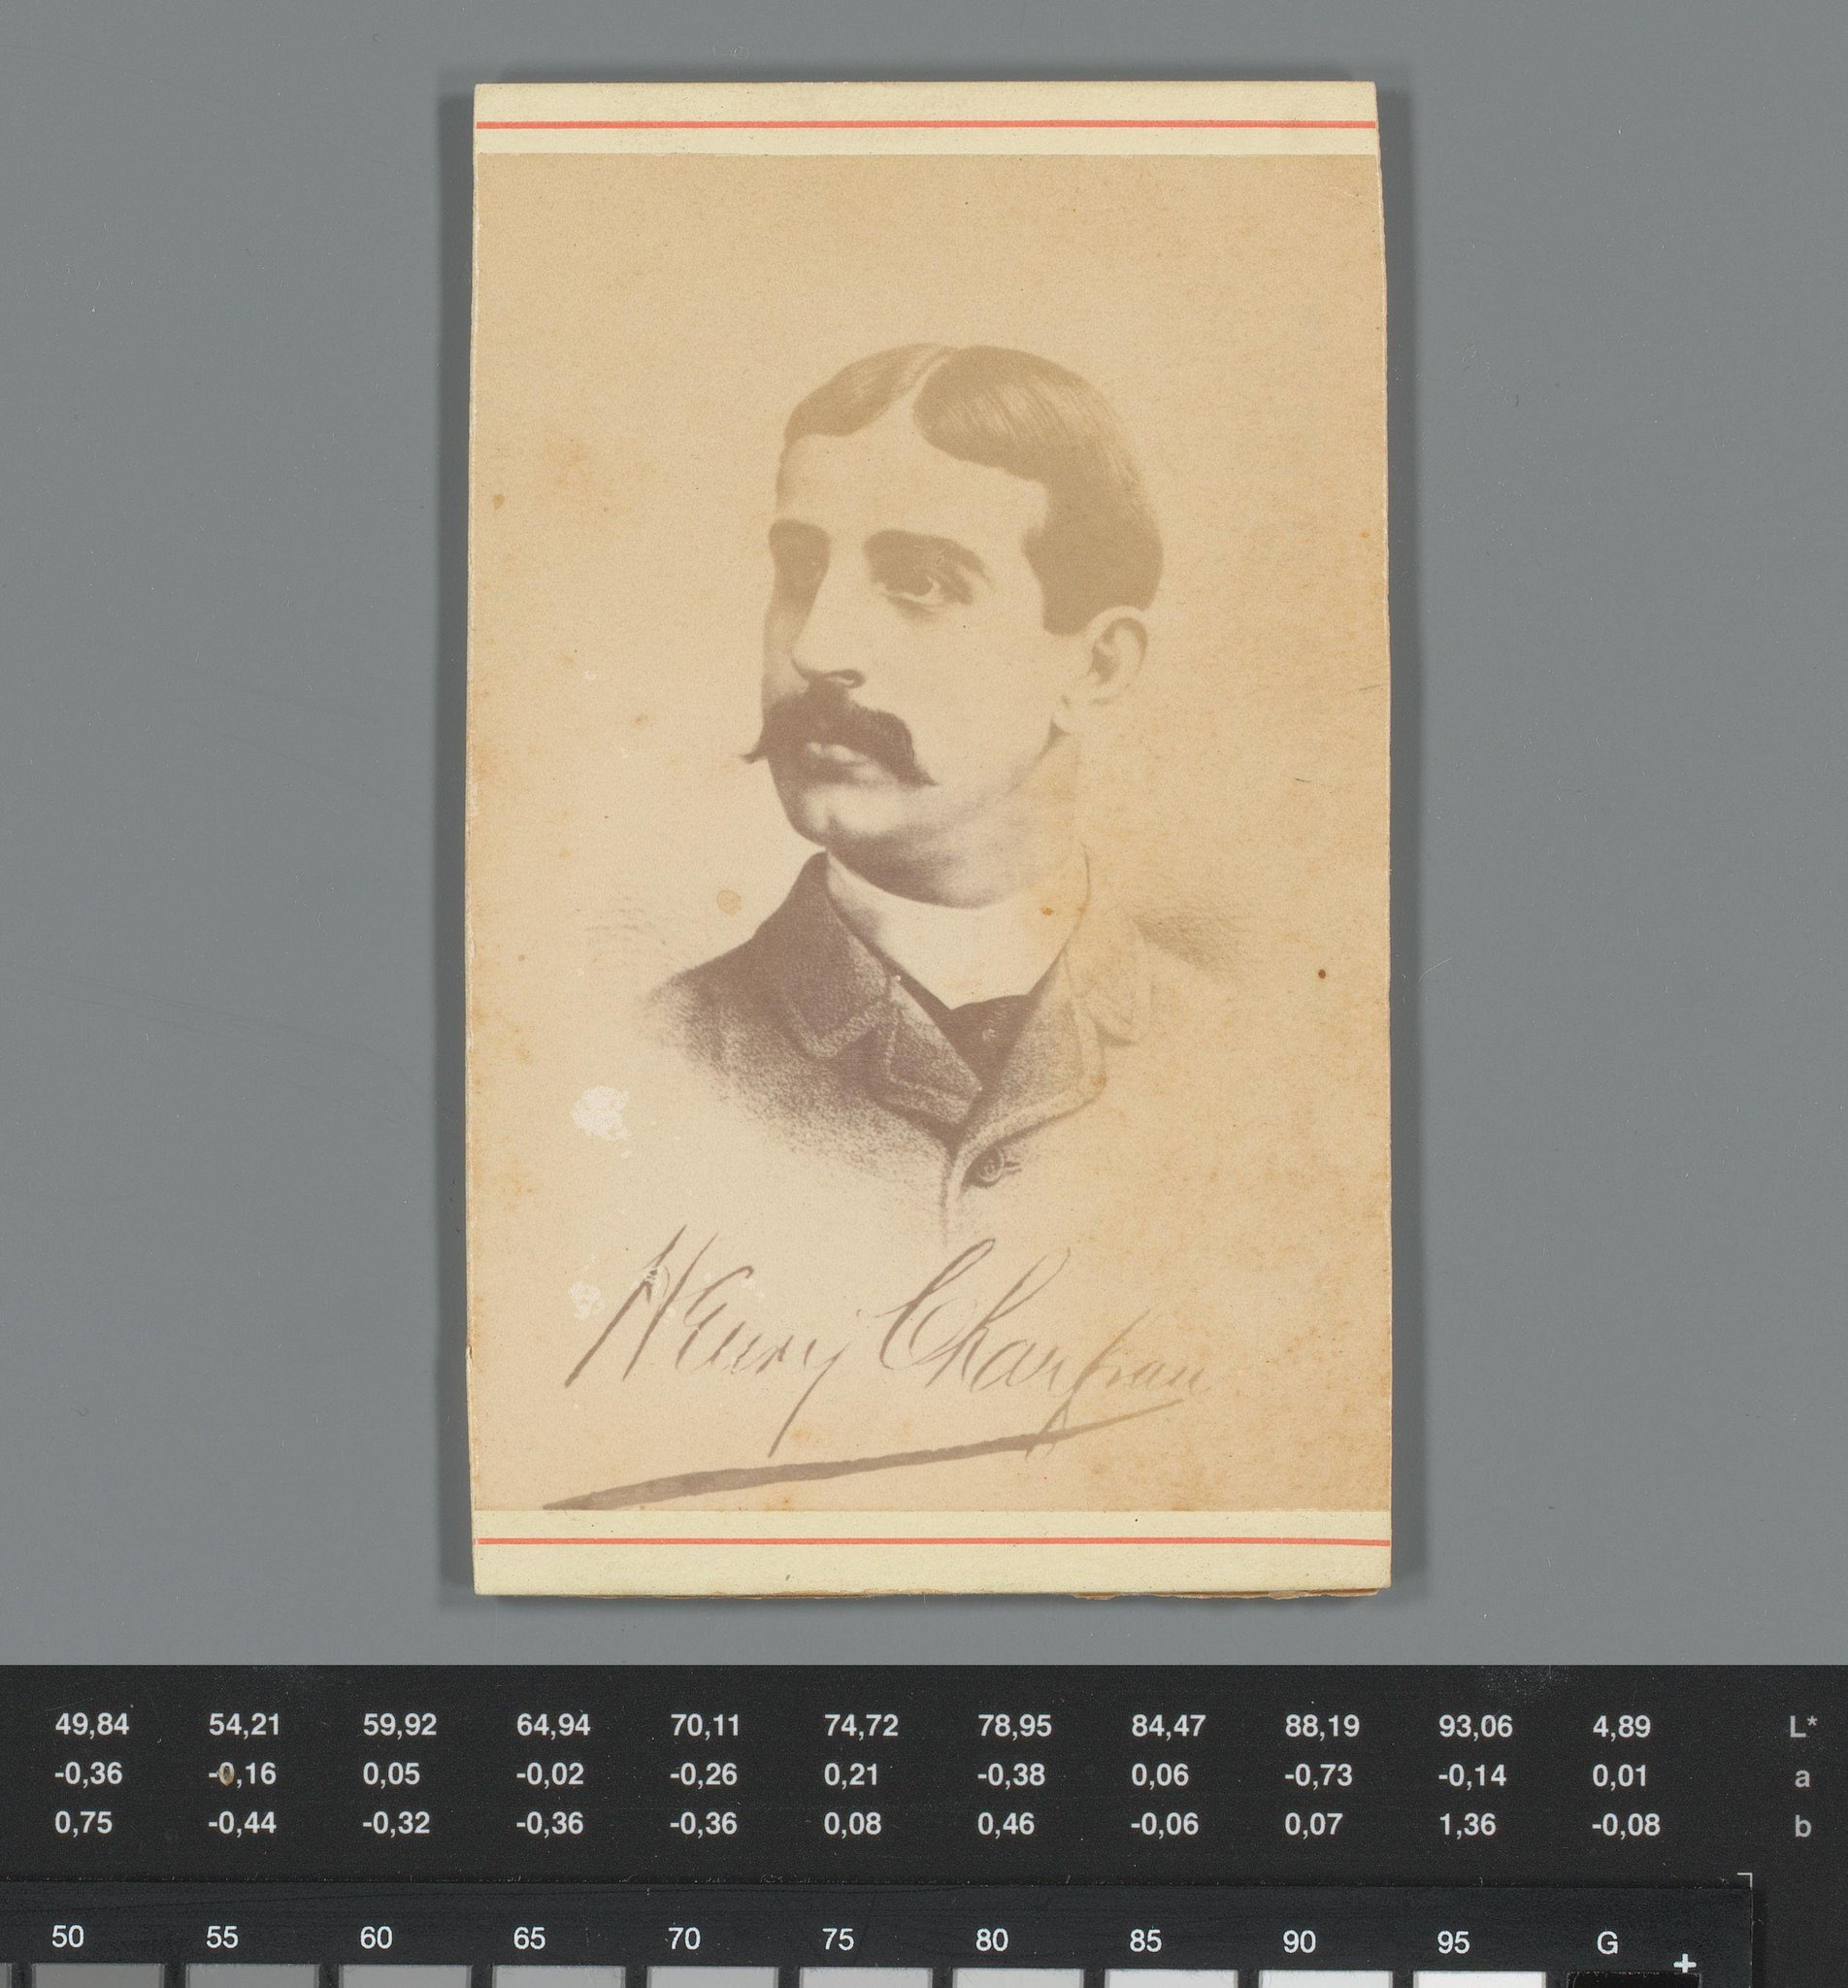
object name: photograph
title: Portret van Henry Chanfrau met reclame voor diens voorstelling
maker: Anonymous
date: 1850-1884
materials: cardboard, photographic support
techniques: albumen print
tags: advertising, historical persons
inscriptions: inscription: ‘(...)’